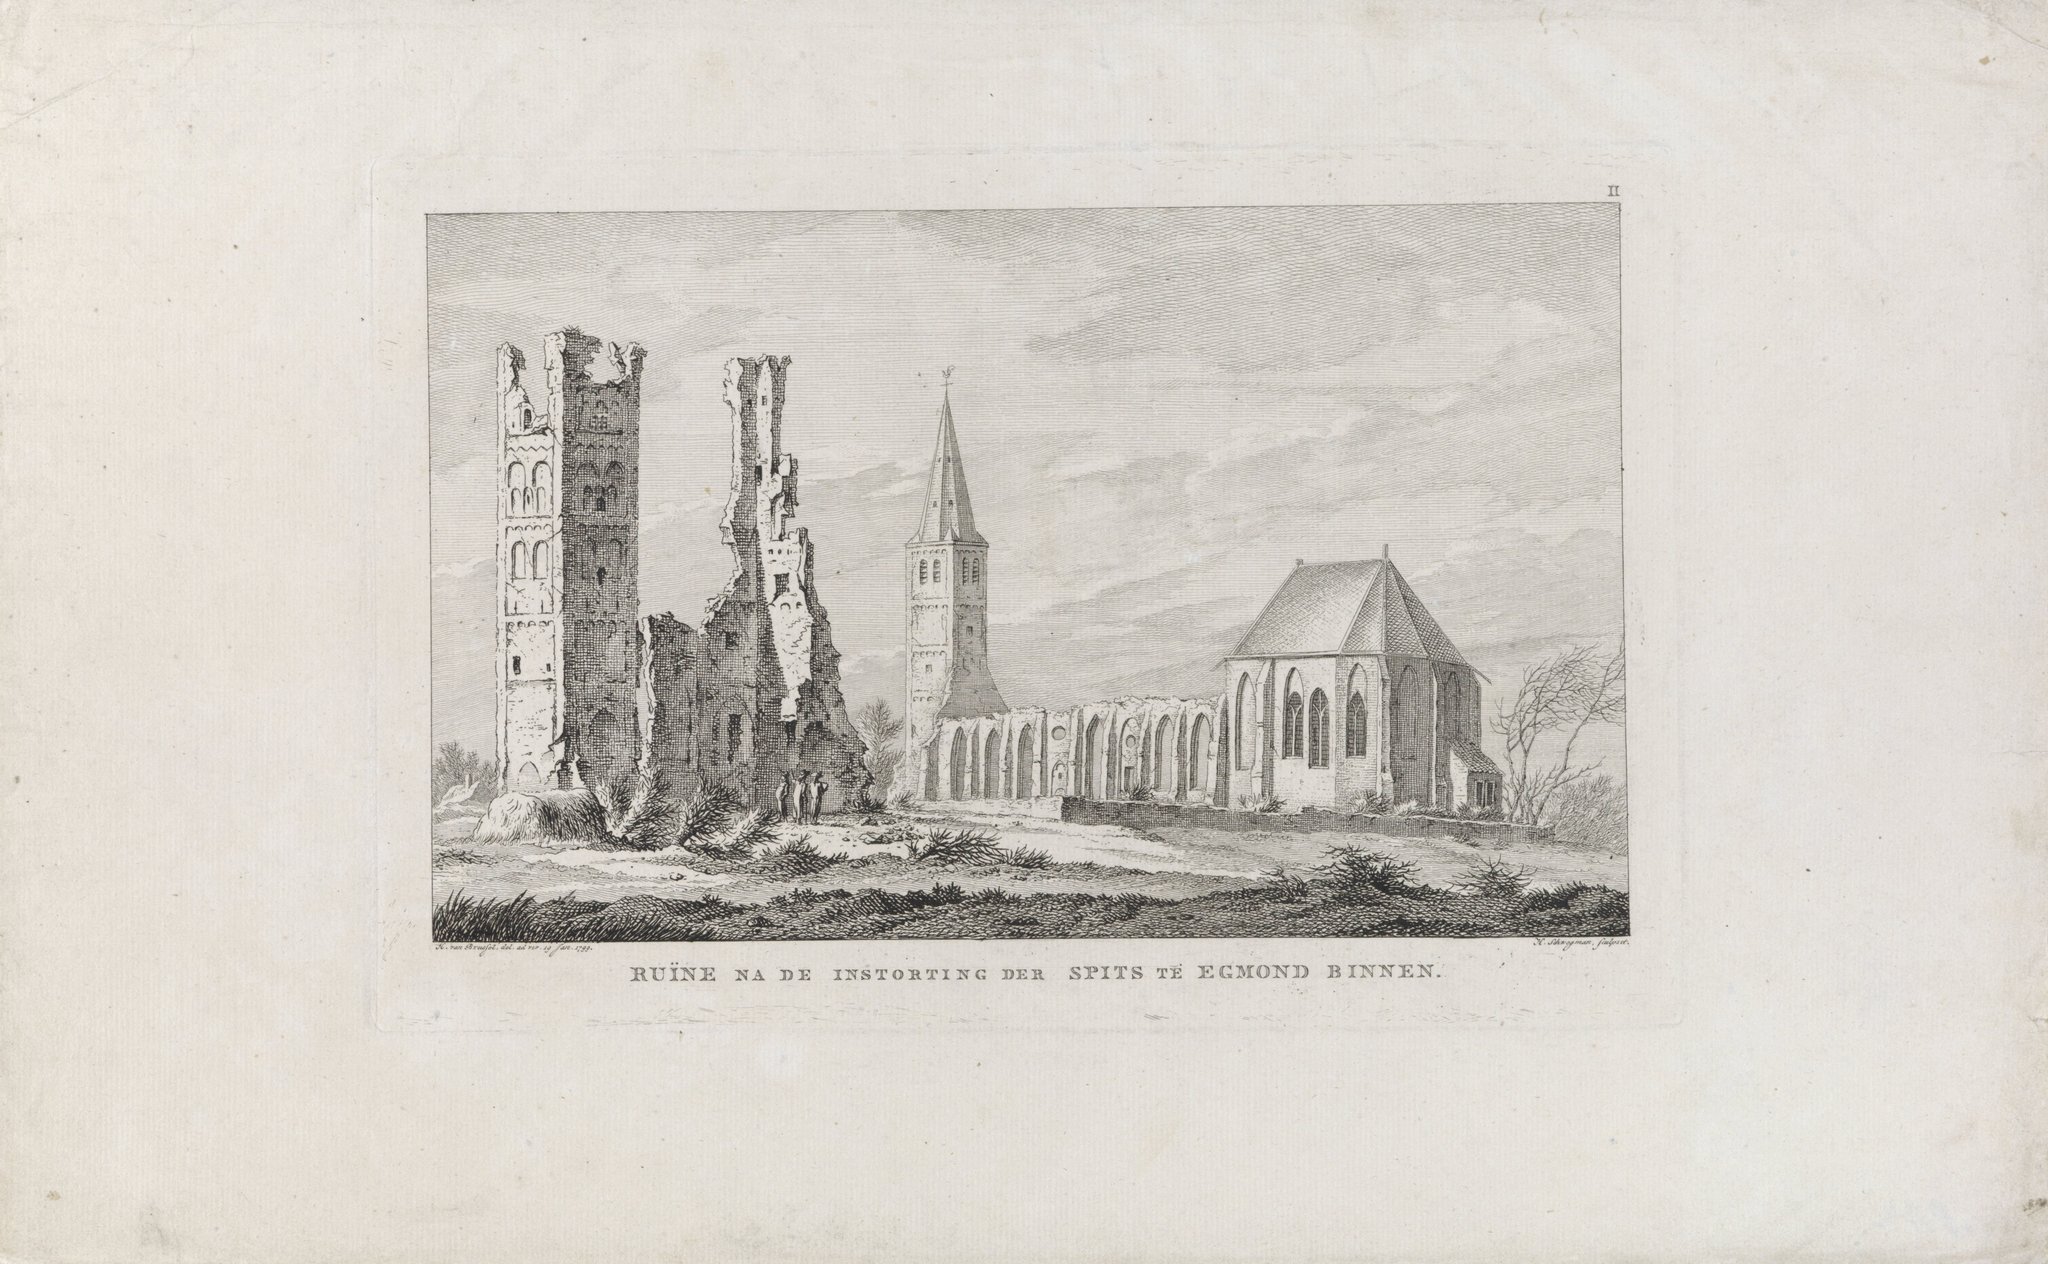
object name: print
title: Ingestorte toren van de Abdijkerk te Egmond, 1799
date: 1799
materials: paper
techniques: engraving, etching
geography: netherlands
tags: ruin of church, monastery, etc.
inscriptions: collector's mark: Lugt 2228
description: Gezicht op de ruïne van de Abdijkerk te Egmond-Binnen, in januari 1799 na het instorten van de toren op 18 december 1798. Genummerd rechtsboven: II. Zie pendant.